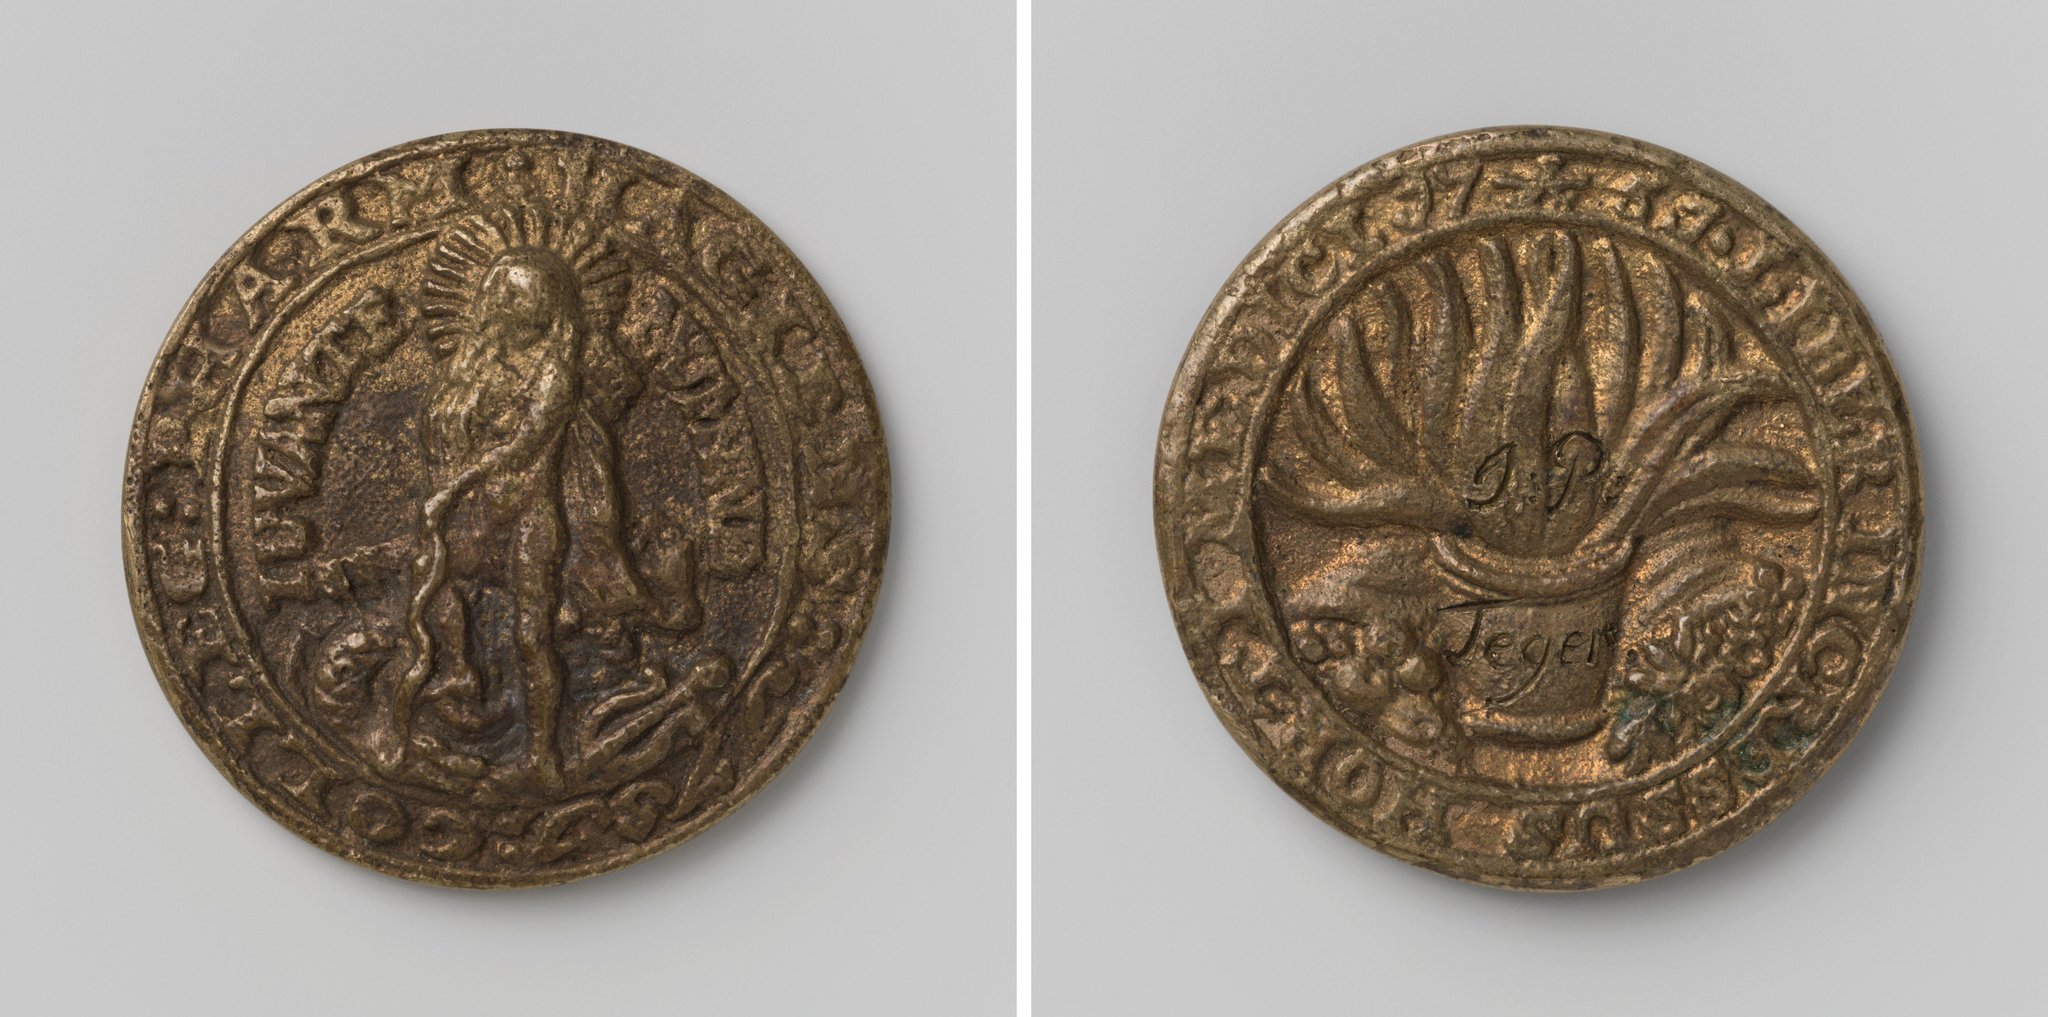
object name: medal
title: Collegium Pharmaceuticum te 's-Gravenhage, toegangspenning voor de hortus medicus voor Josias Petrus Teeger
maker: Anonymous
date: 1751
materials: brass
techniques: casting, engraving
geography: the hague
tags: the hague